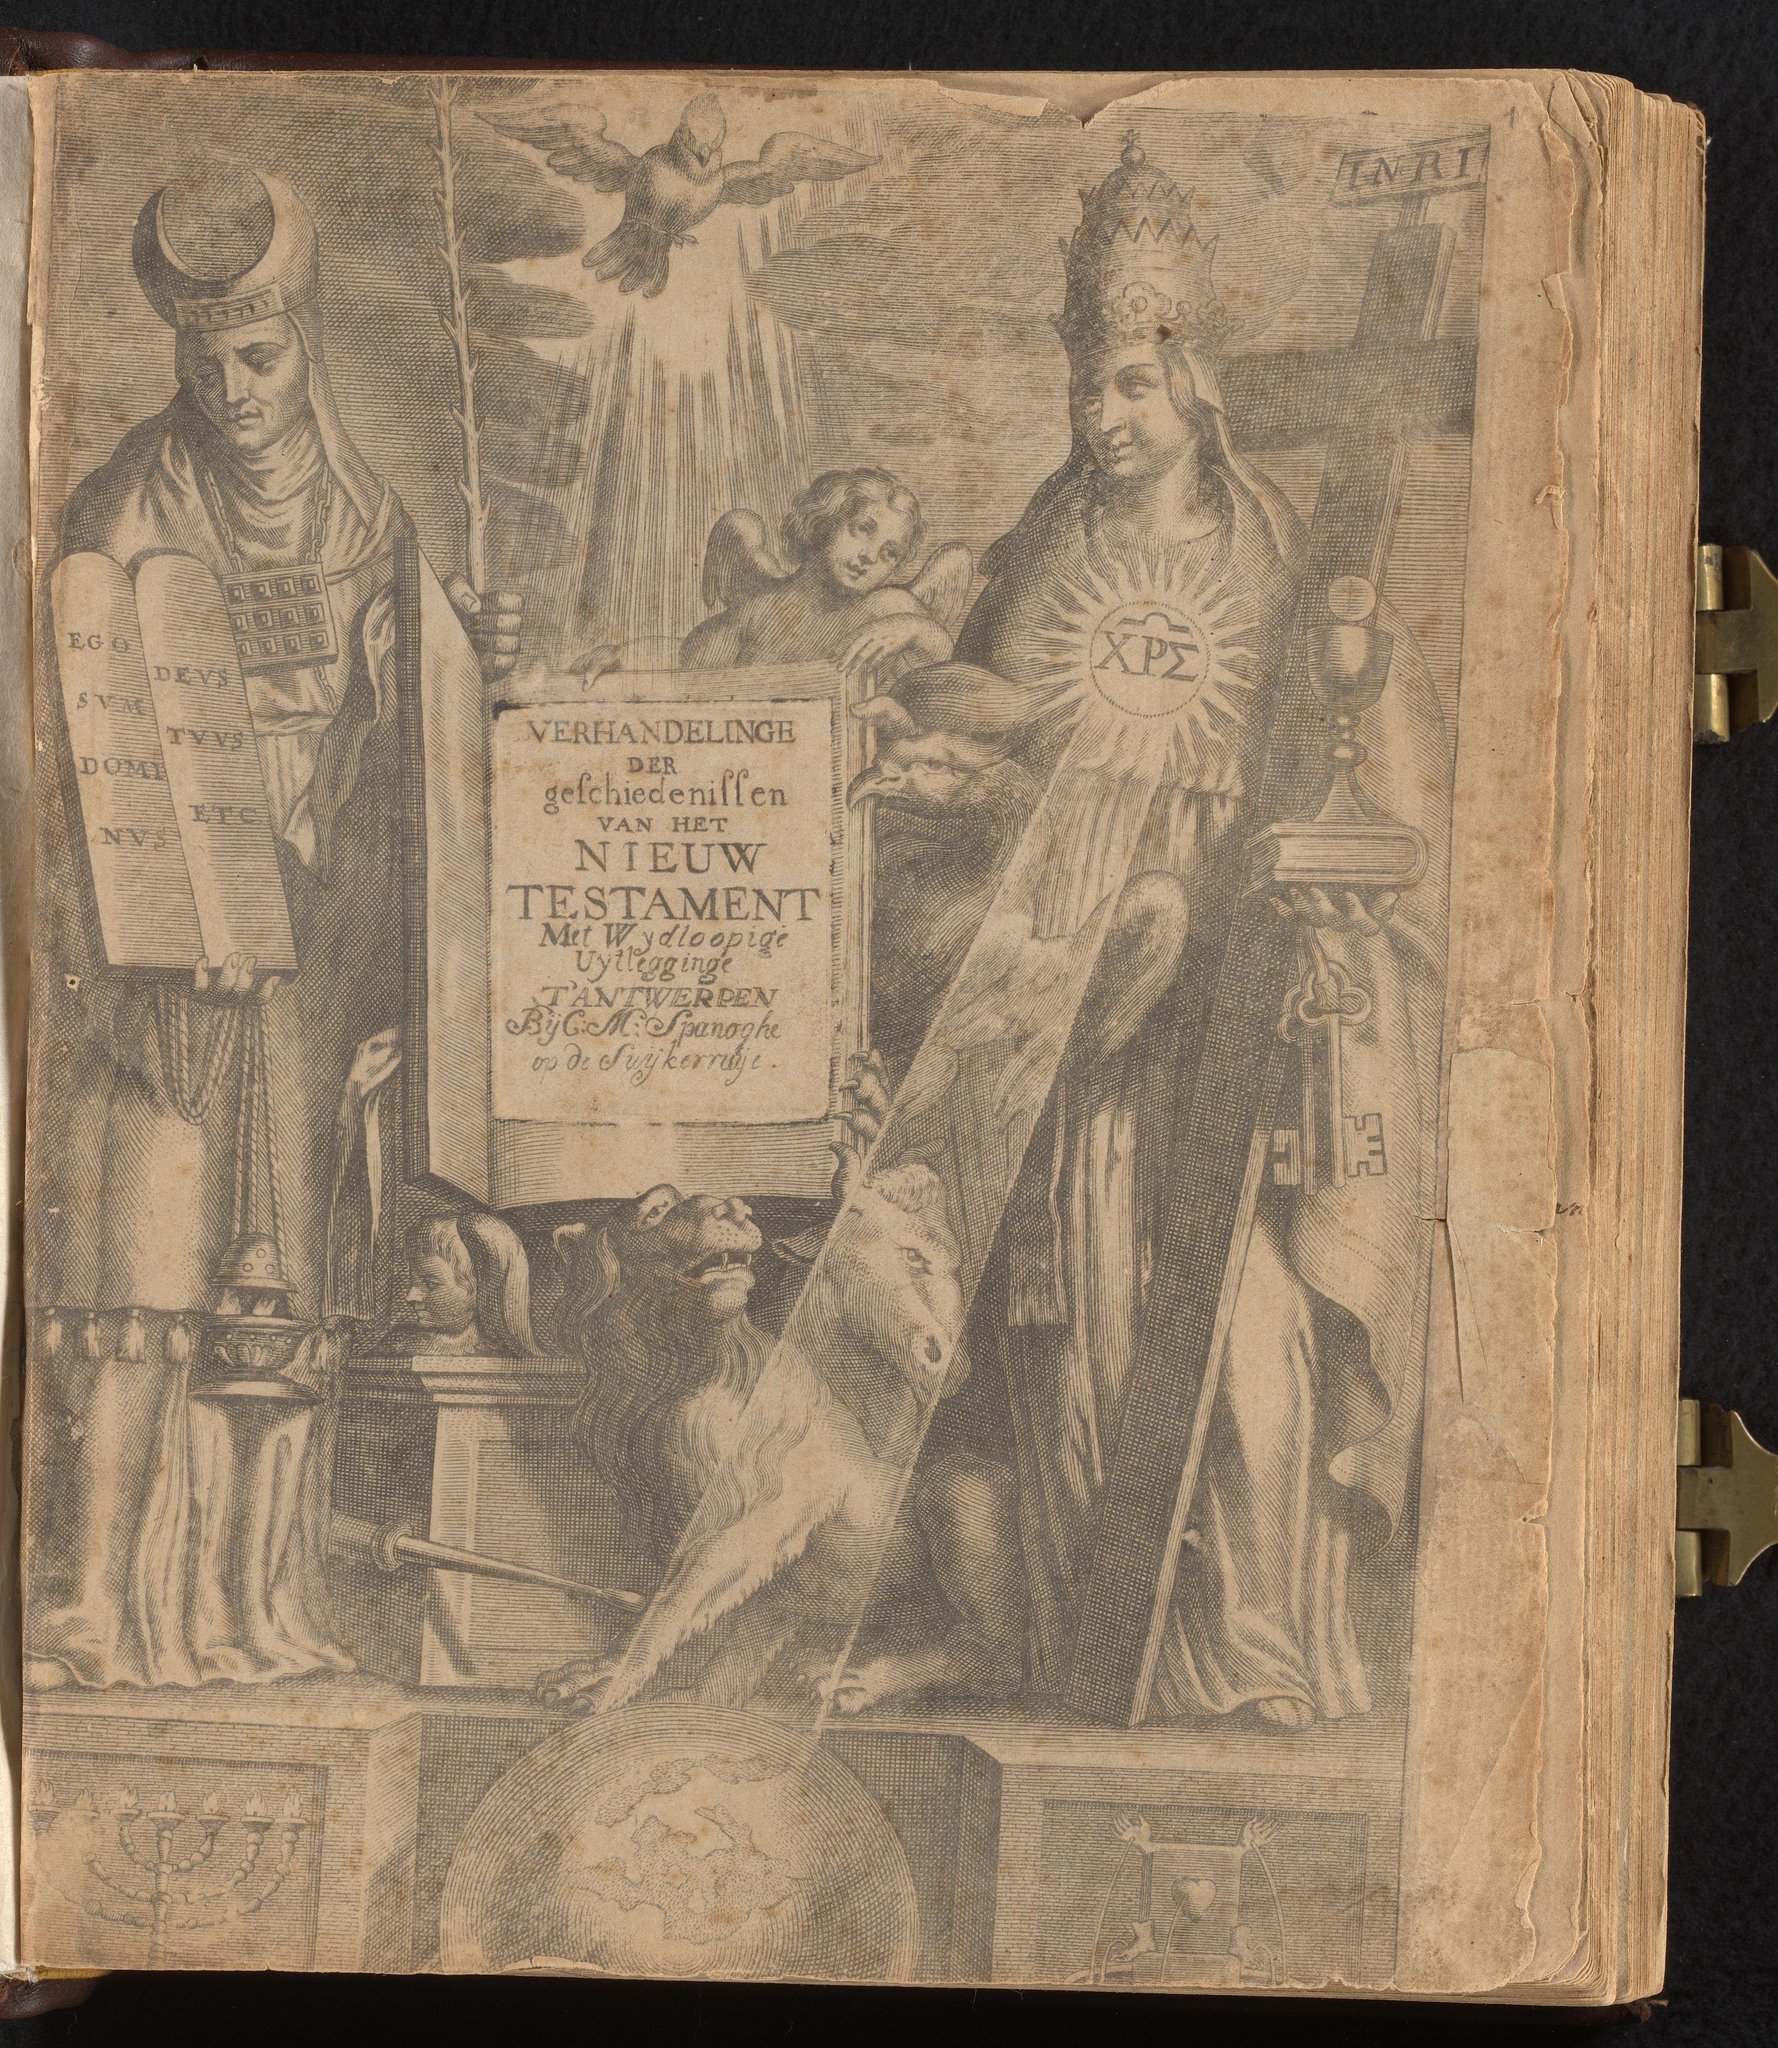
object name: print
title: Allegorische voorstelling met het Oude en Nieuwe Geloof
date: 1650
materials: paper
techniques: engraving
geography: southern netherlands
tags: old testament and new testament ~ christian doctrine, the four symbols of the evangelists, 'the apocalyptic beasts', globe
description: Prent in: s.n. Aldernouwkeurigste verhandelinge der geschiedenissen van het Nieuw Testament (...). Antwerpen: Cornelis Marten Spanoghe,1784, fol. 5. Eerdere staat van de prent gebruikt in: s.n. Biblia Sacra Vulgate Editionis Sixti V. Pont. Max. Iussu recognita atque edita. Antwerpen: Officina Plantiniana, 1650. Eerdere staat van de prent ook gebruikt in: s.n. Biblia sacra dat is de geheele heylighe schrifture (...). Amsterdam: Pieter Jacobsz Paets, 1657. Eerdere staat van de prent ook gebruikt in: s.n. Biblia Sacra Vulgate Editionis Sixti V. Pont. Max. Iussu recognita atque edita. Antwerpen: Jan Verdussen, 1740.